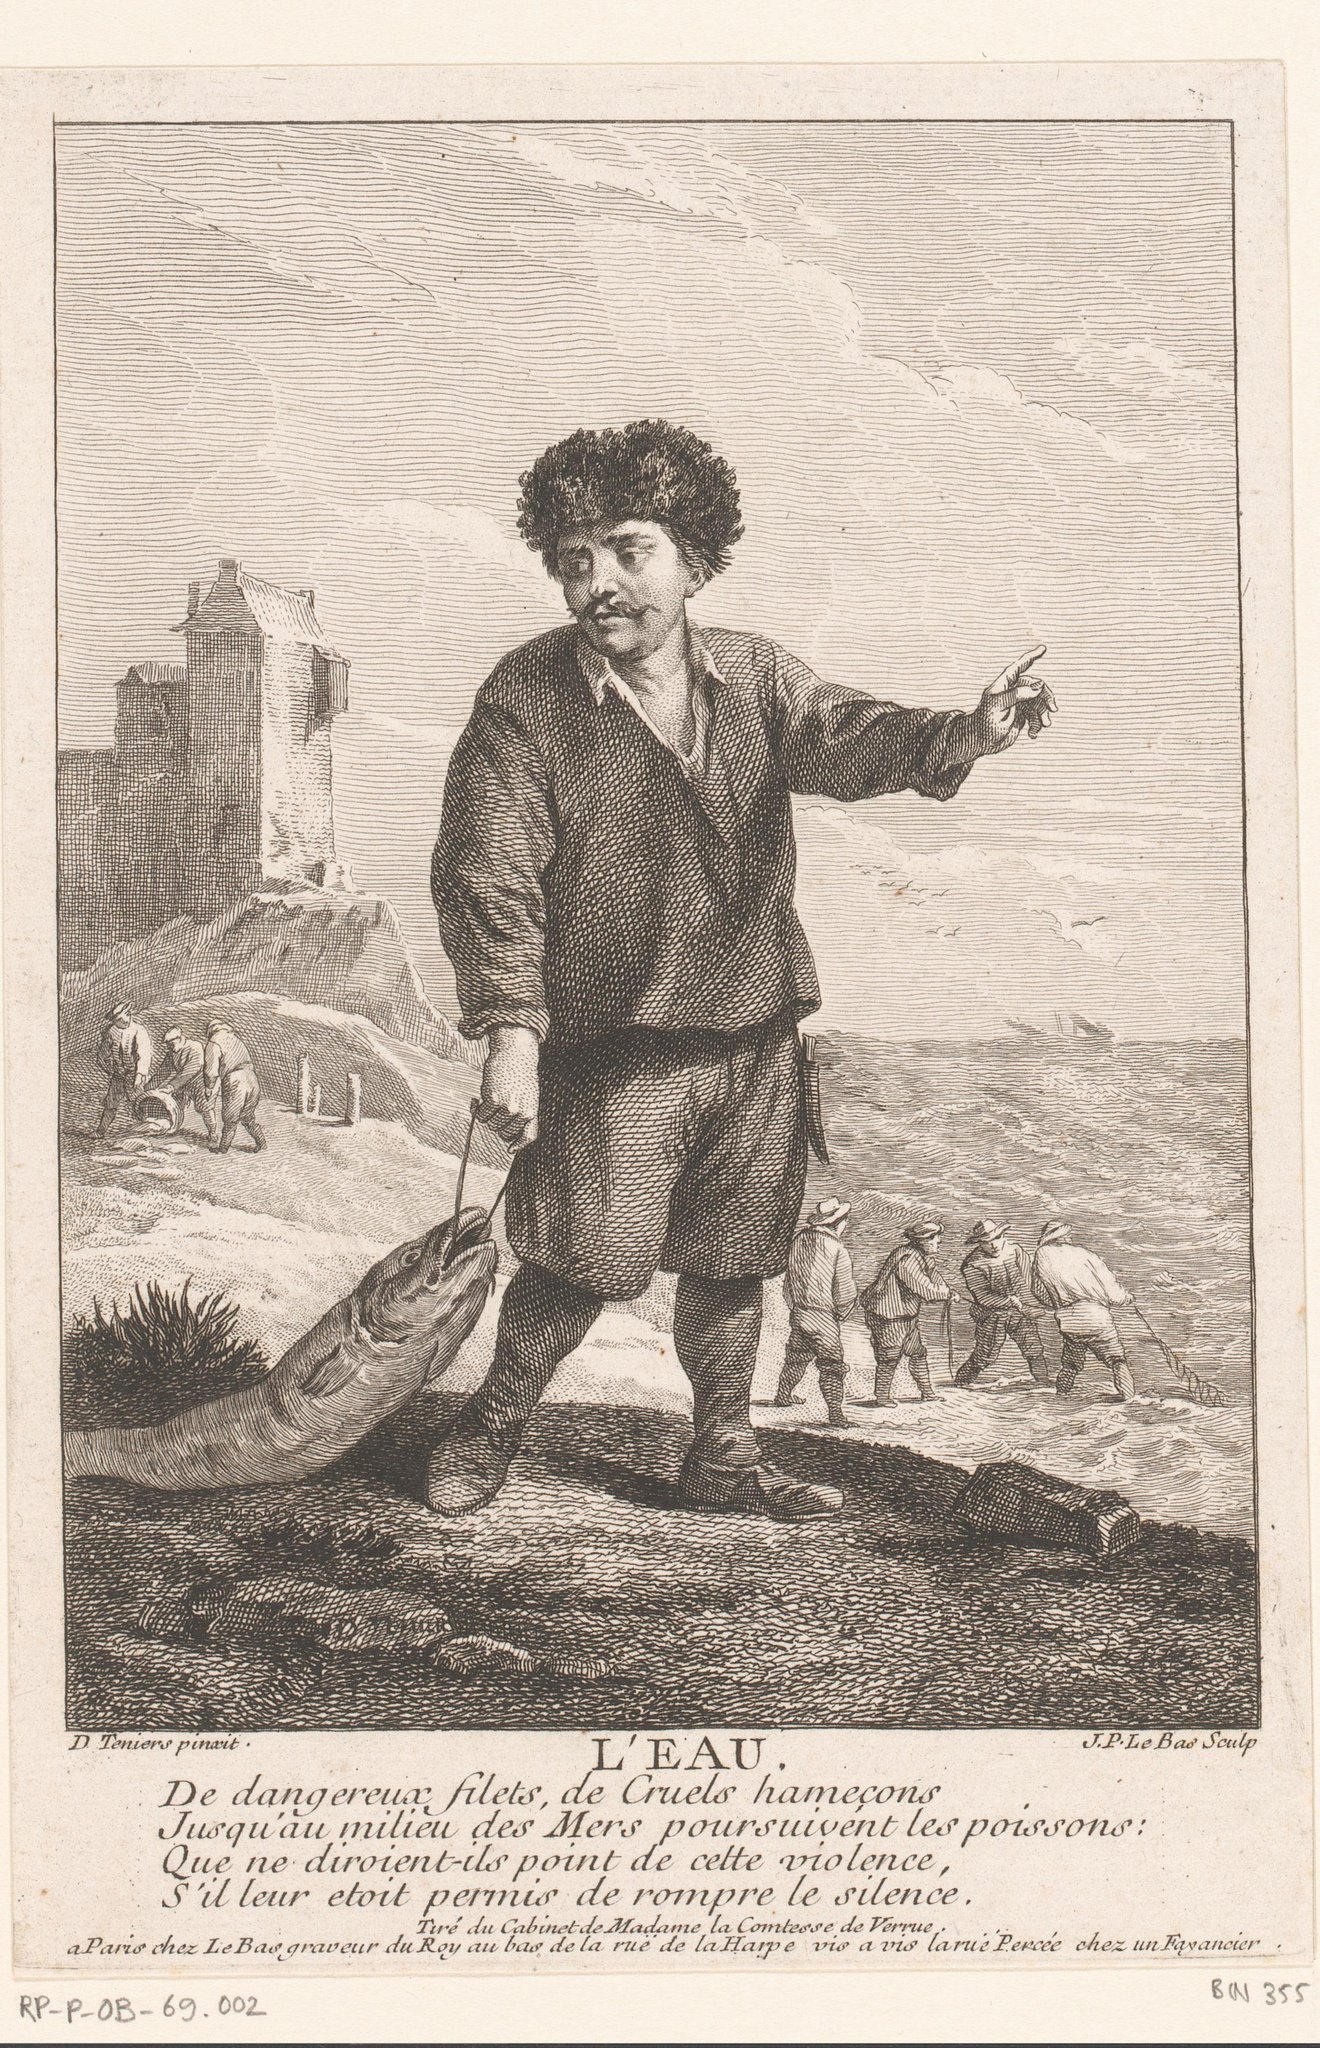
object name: print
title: De vier elementen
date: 1736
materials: paper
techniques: engraving, etching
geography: paris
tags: the four elements, and ether, the fifth element, water (one of the four elements), fisherman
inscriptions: collector's mark: Lugt 240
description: Maakt deel uit van een vierdelige serie met de vier elementen in menselijke gedaanten.